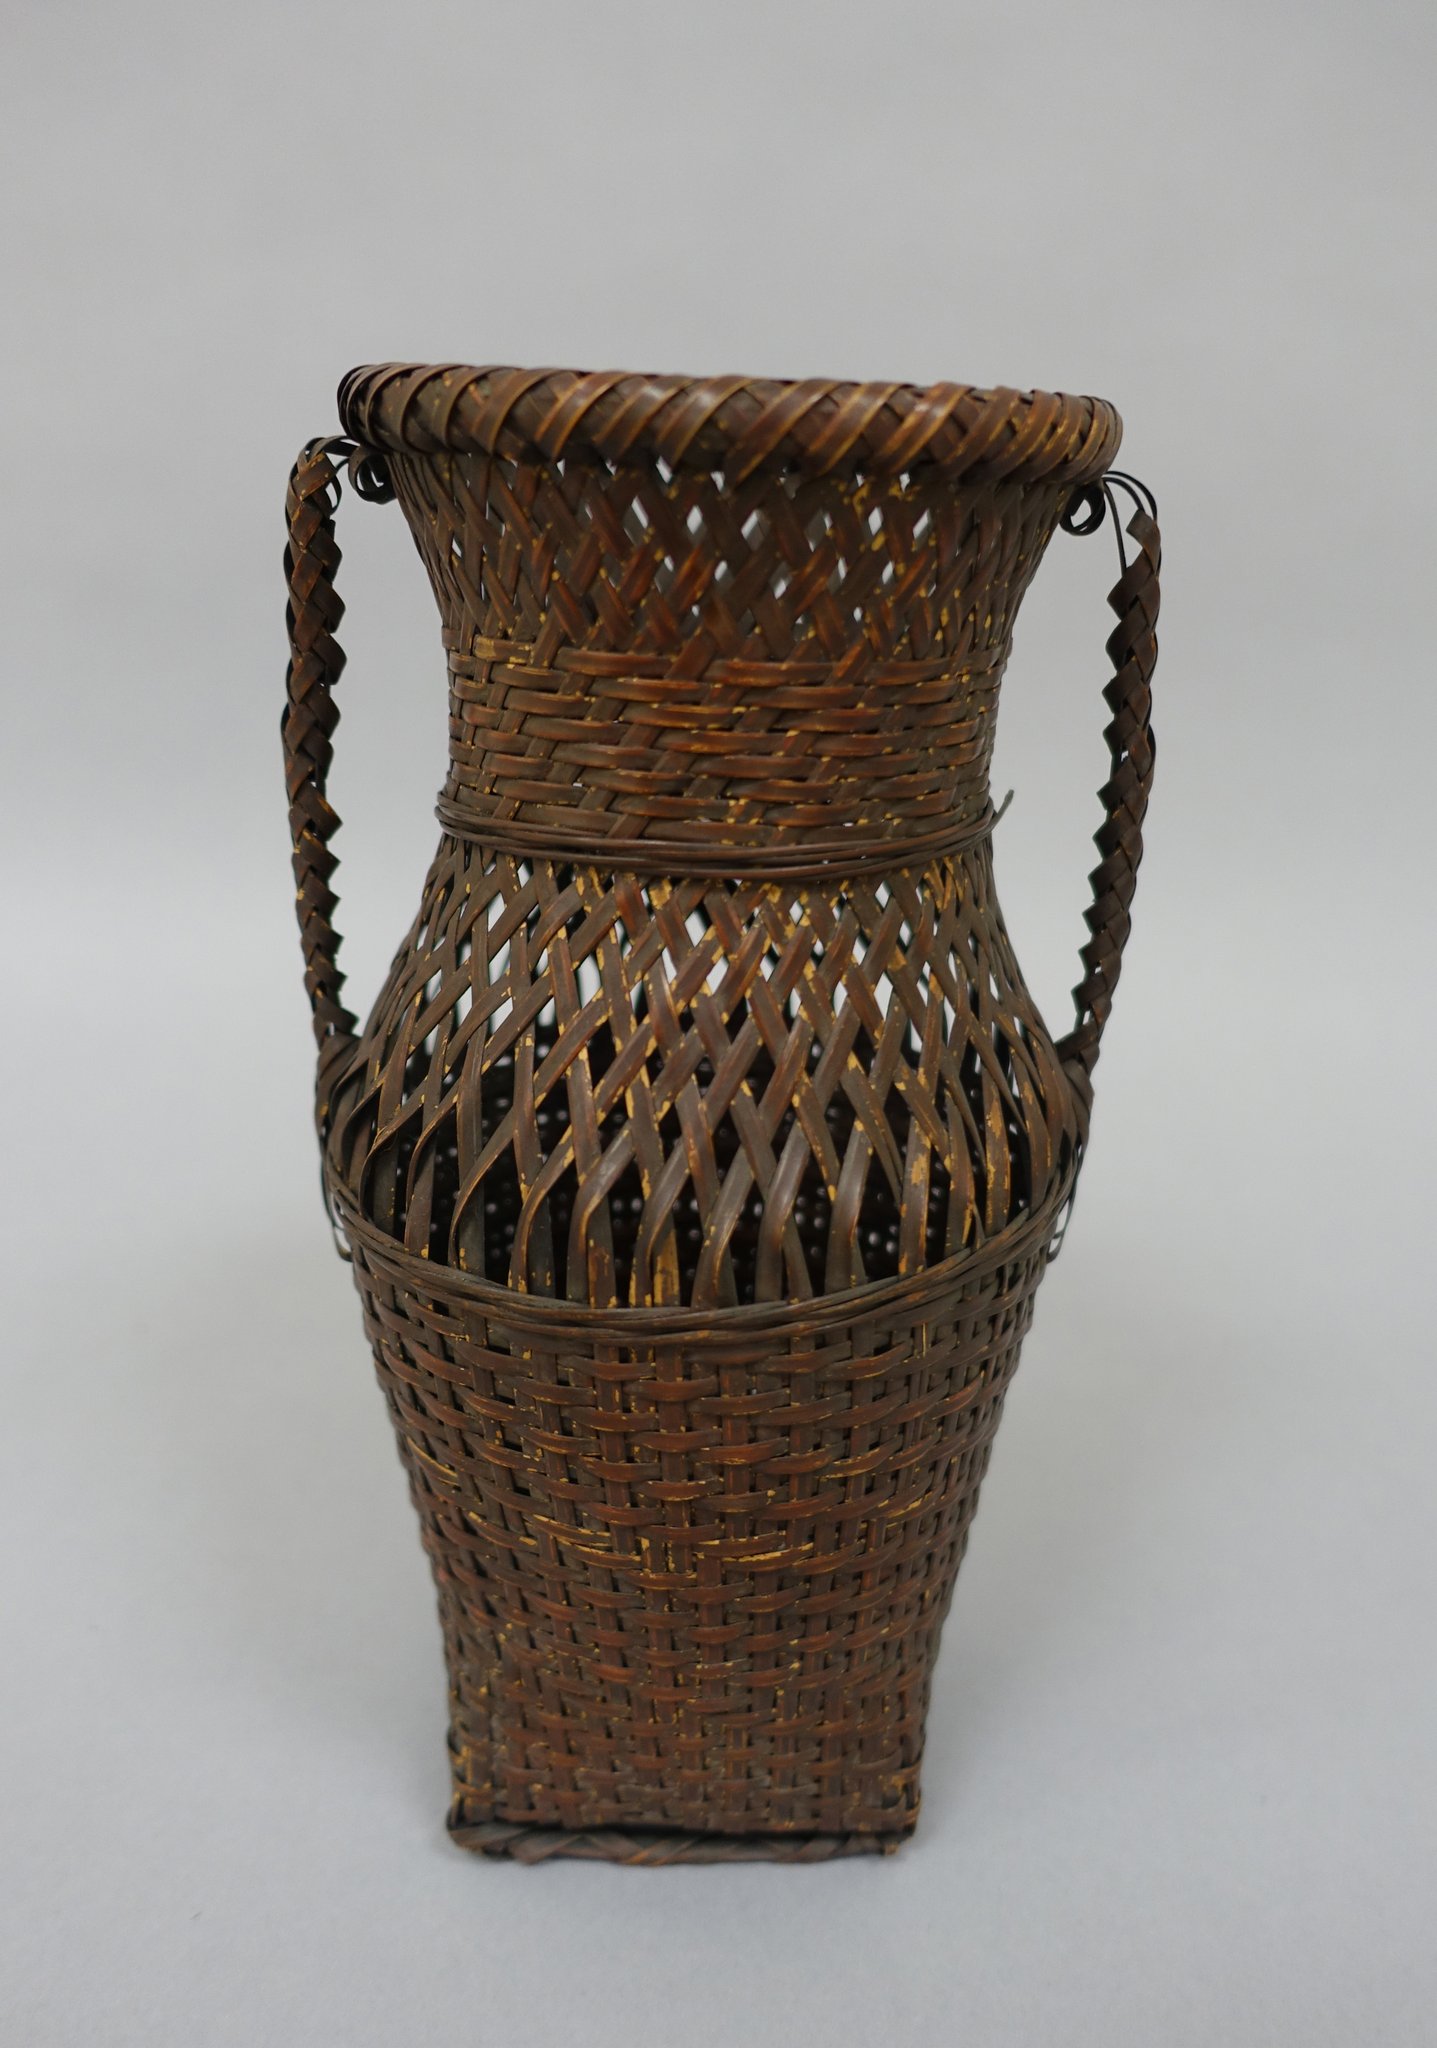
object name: basket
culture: japanese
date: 1801-1900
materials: bamboo